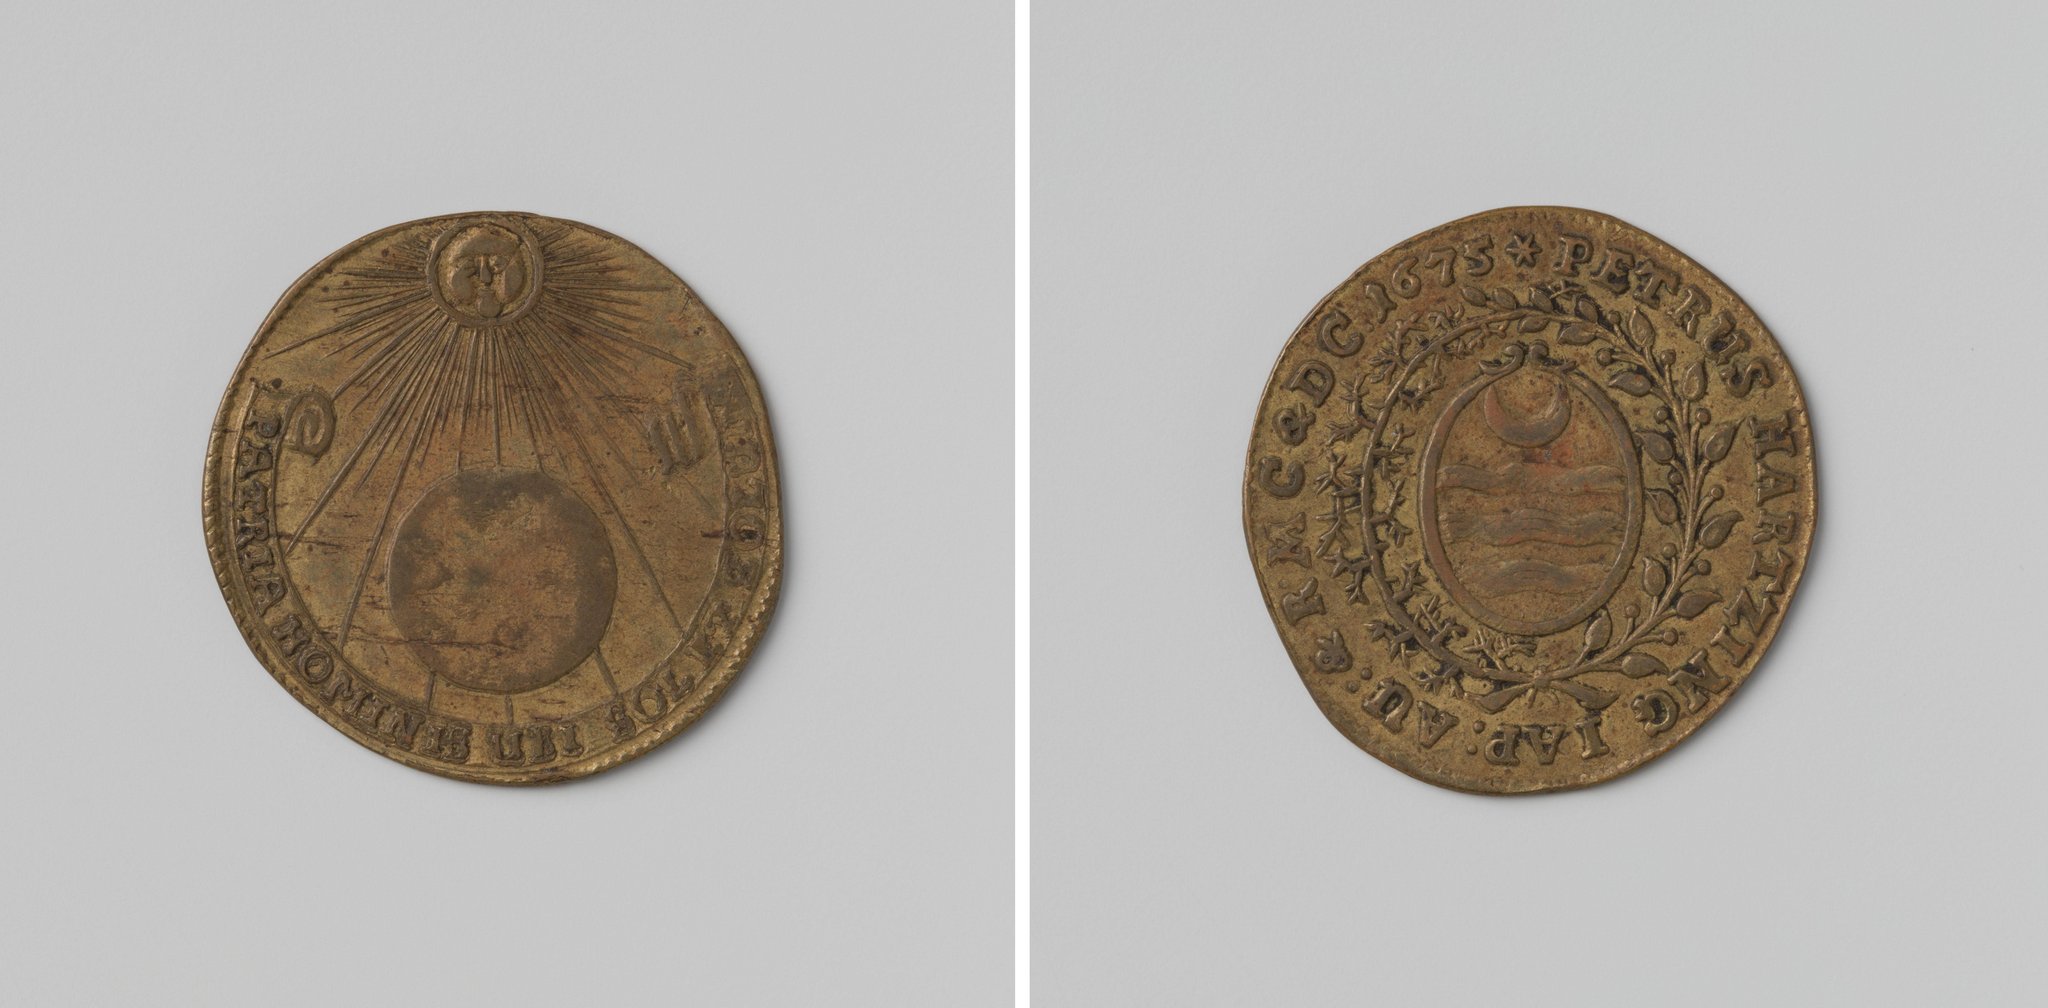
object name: jeton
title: Petrus Hartzing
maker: Anonymous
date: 1675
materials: copper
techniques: striking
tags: petrus hartzing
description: Koperen penning. Voorzijde: wereldbol beschenen door stralende zon binnen omschrift op wimpel. Keerzijde: ovaal wapenschild binnen tot krans samengebonden bladertakken en omschrift